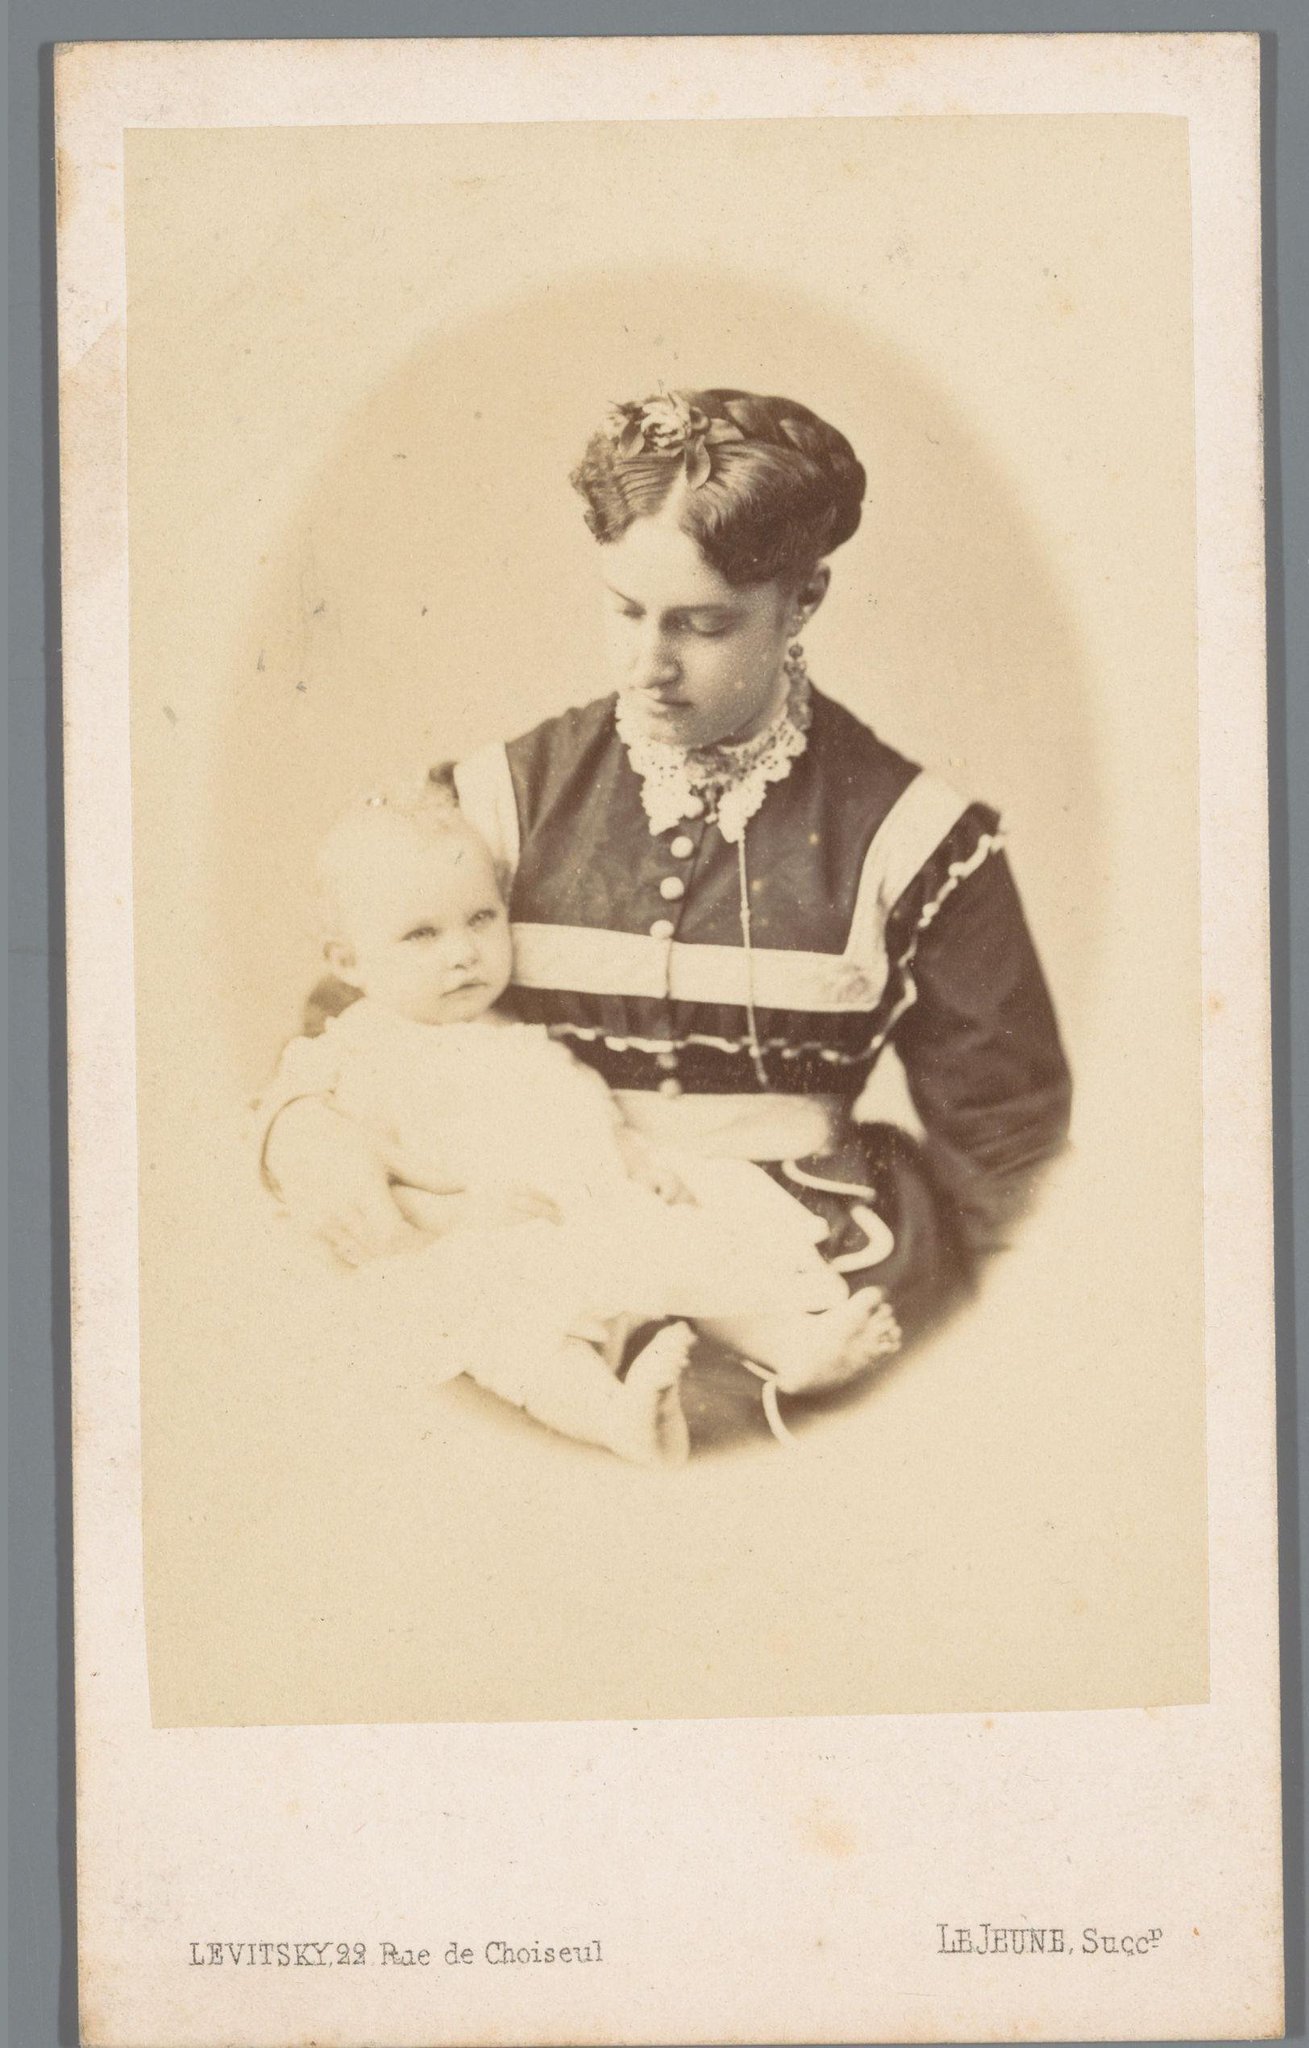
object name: photograph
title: Portret van een onbekende vrouw met een kind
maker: augustin aimé joseph le jeune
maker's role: fotograaf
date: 1865-1880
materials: cardboard, paper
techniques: albumen print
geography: paris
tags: anonymous historical person portrayed, mother and child(ren), woman and child(ren) (family group), paris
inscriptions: inscription: ‘Levitsky, 22, Rue de Choiseul Le Jeune, Succr.’